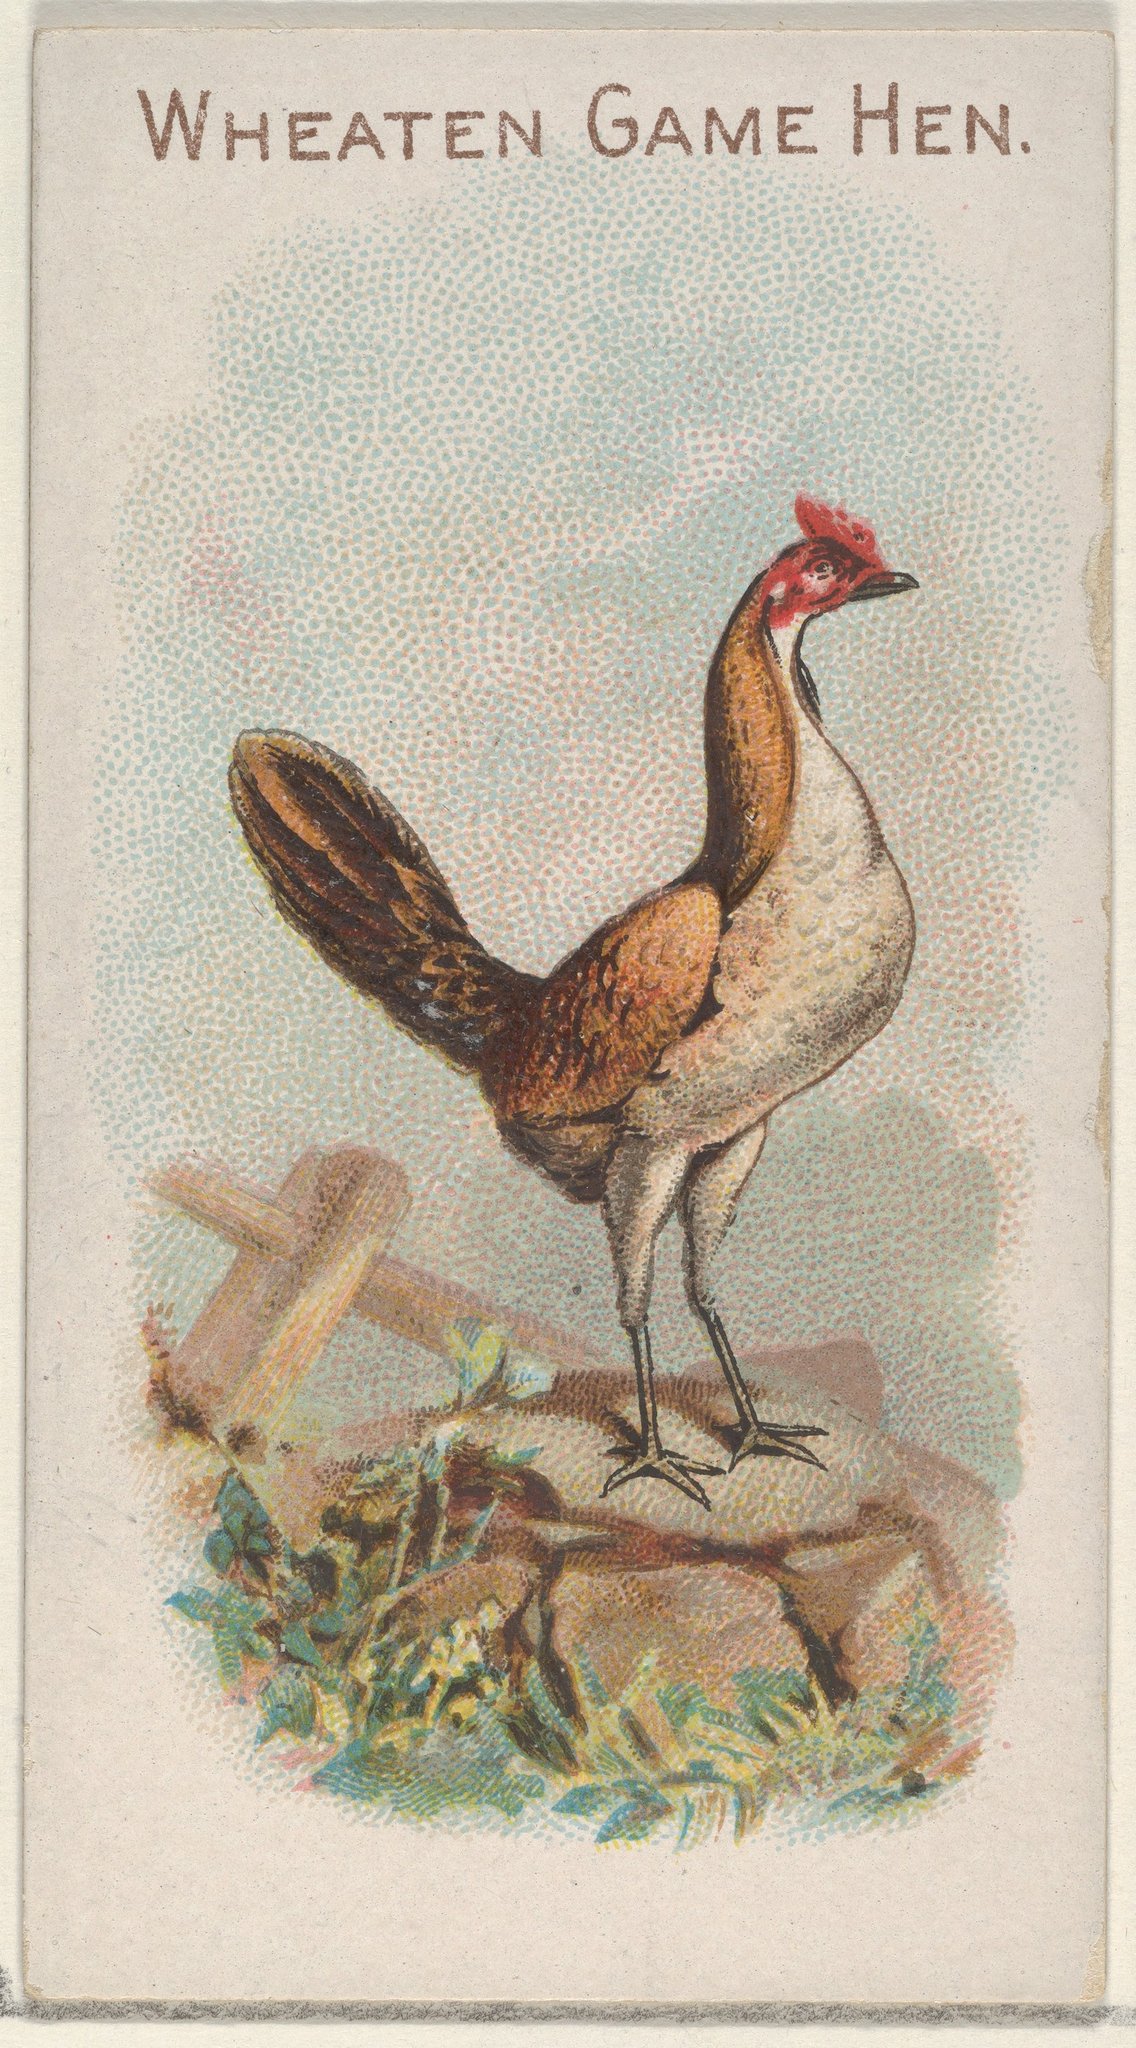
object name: print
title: Wheaten Game Hen, from the Prize and Game Chickens series (N20) for Allen & Ginter Cigarettes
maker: allen & ginter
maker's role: publisher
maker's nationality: american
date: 1891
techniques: color lithograph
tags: chickens